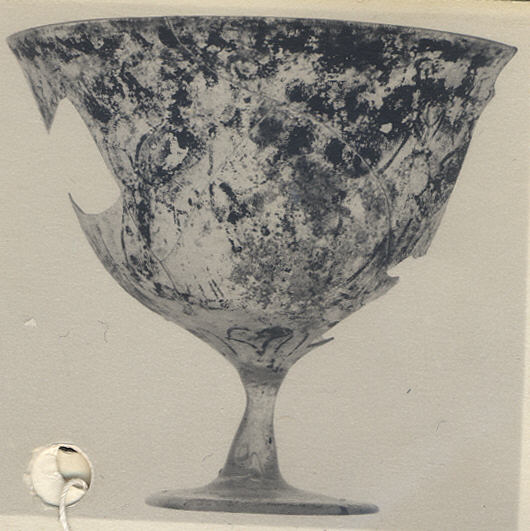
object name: goblet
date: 301-400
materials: glass